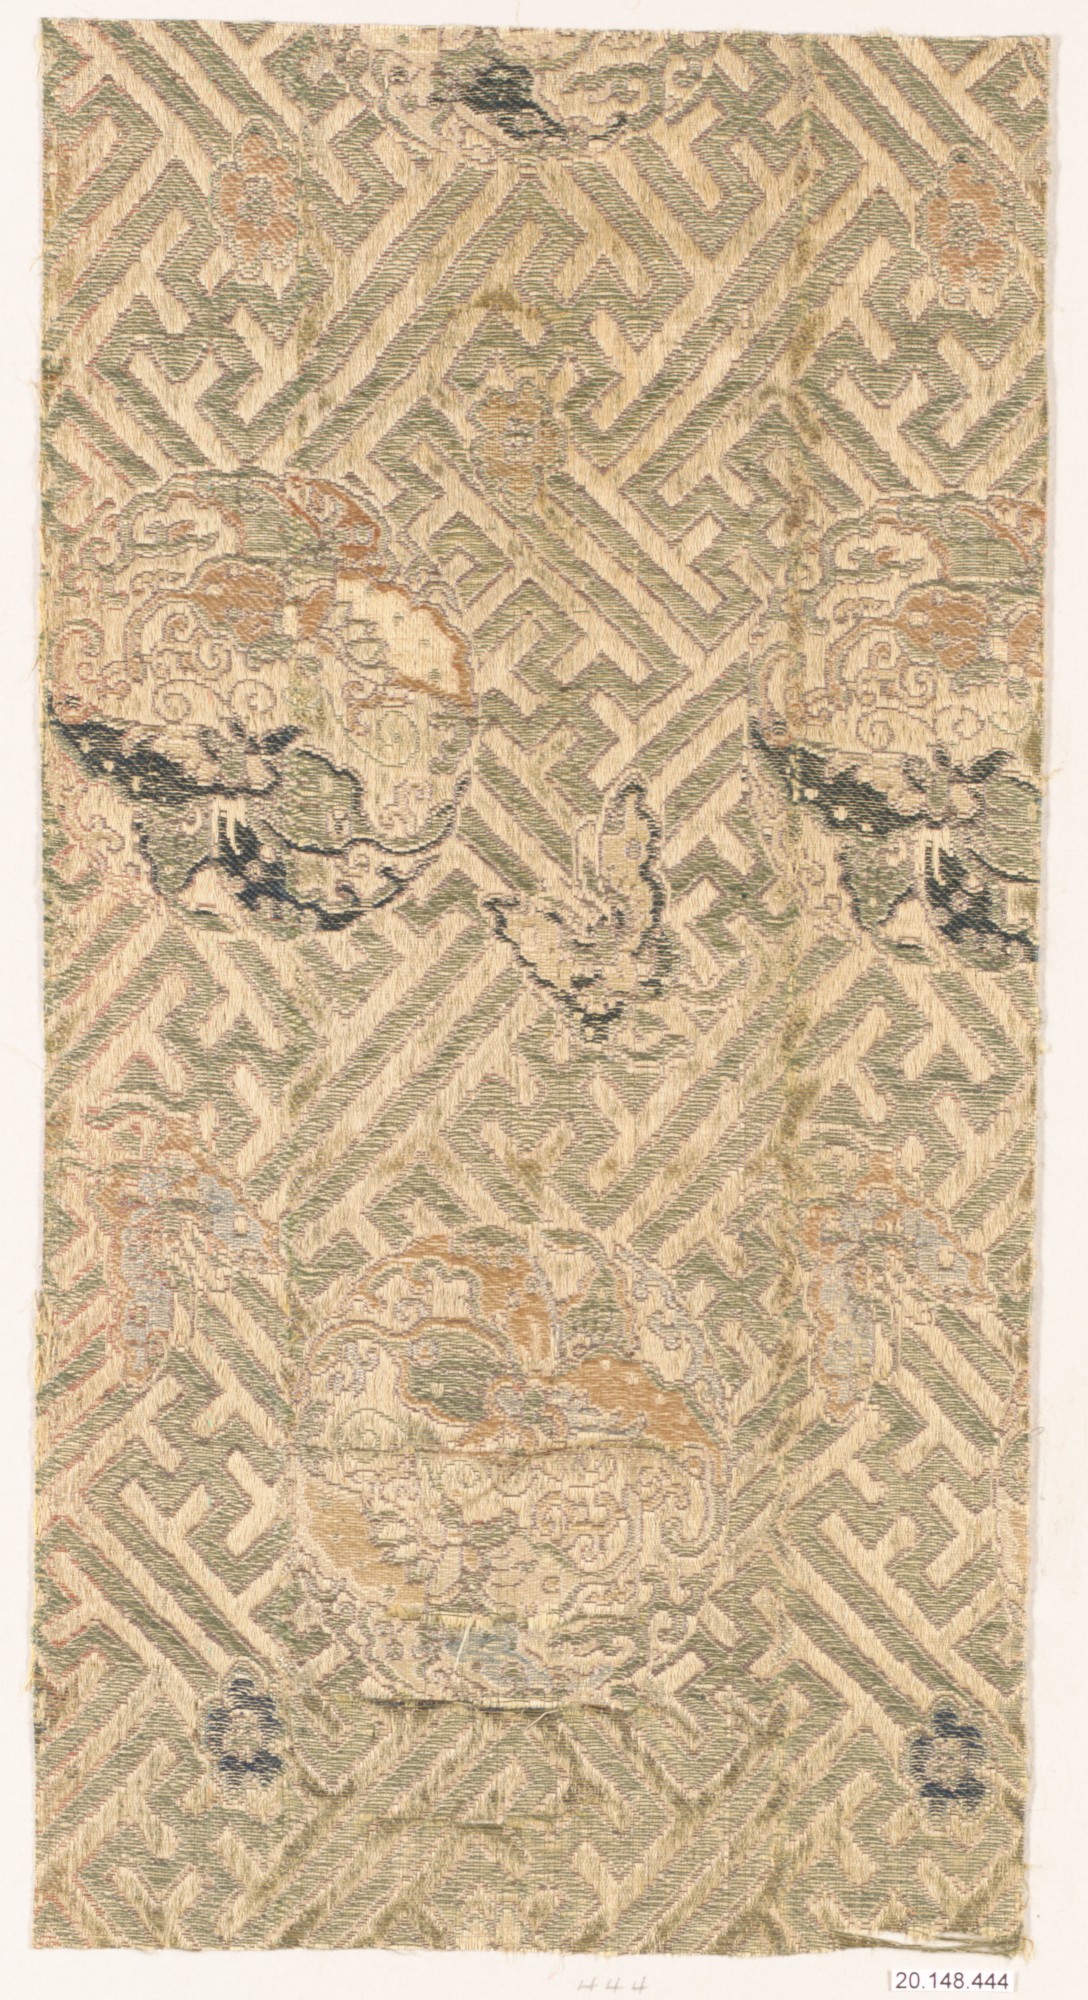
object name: piece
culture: chinese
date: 1701-1800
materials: silk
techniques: compound weave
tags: butterflies